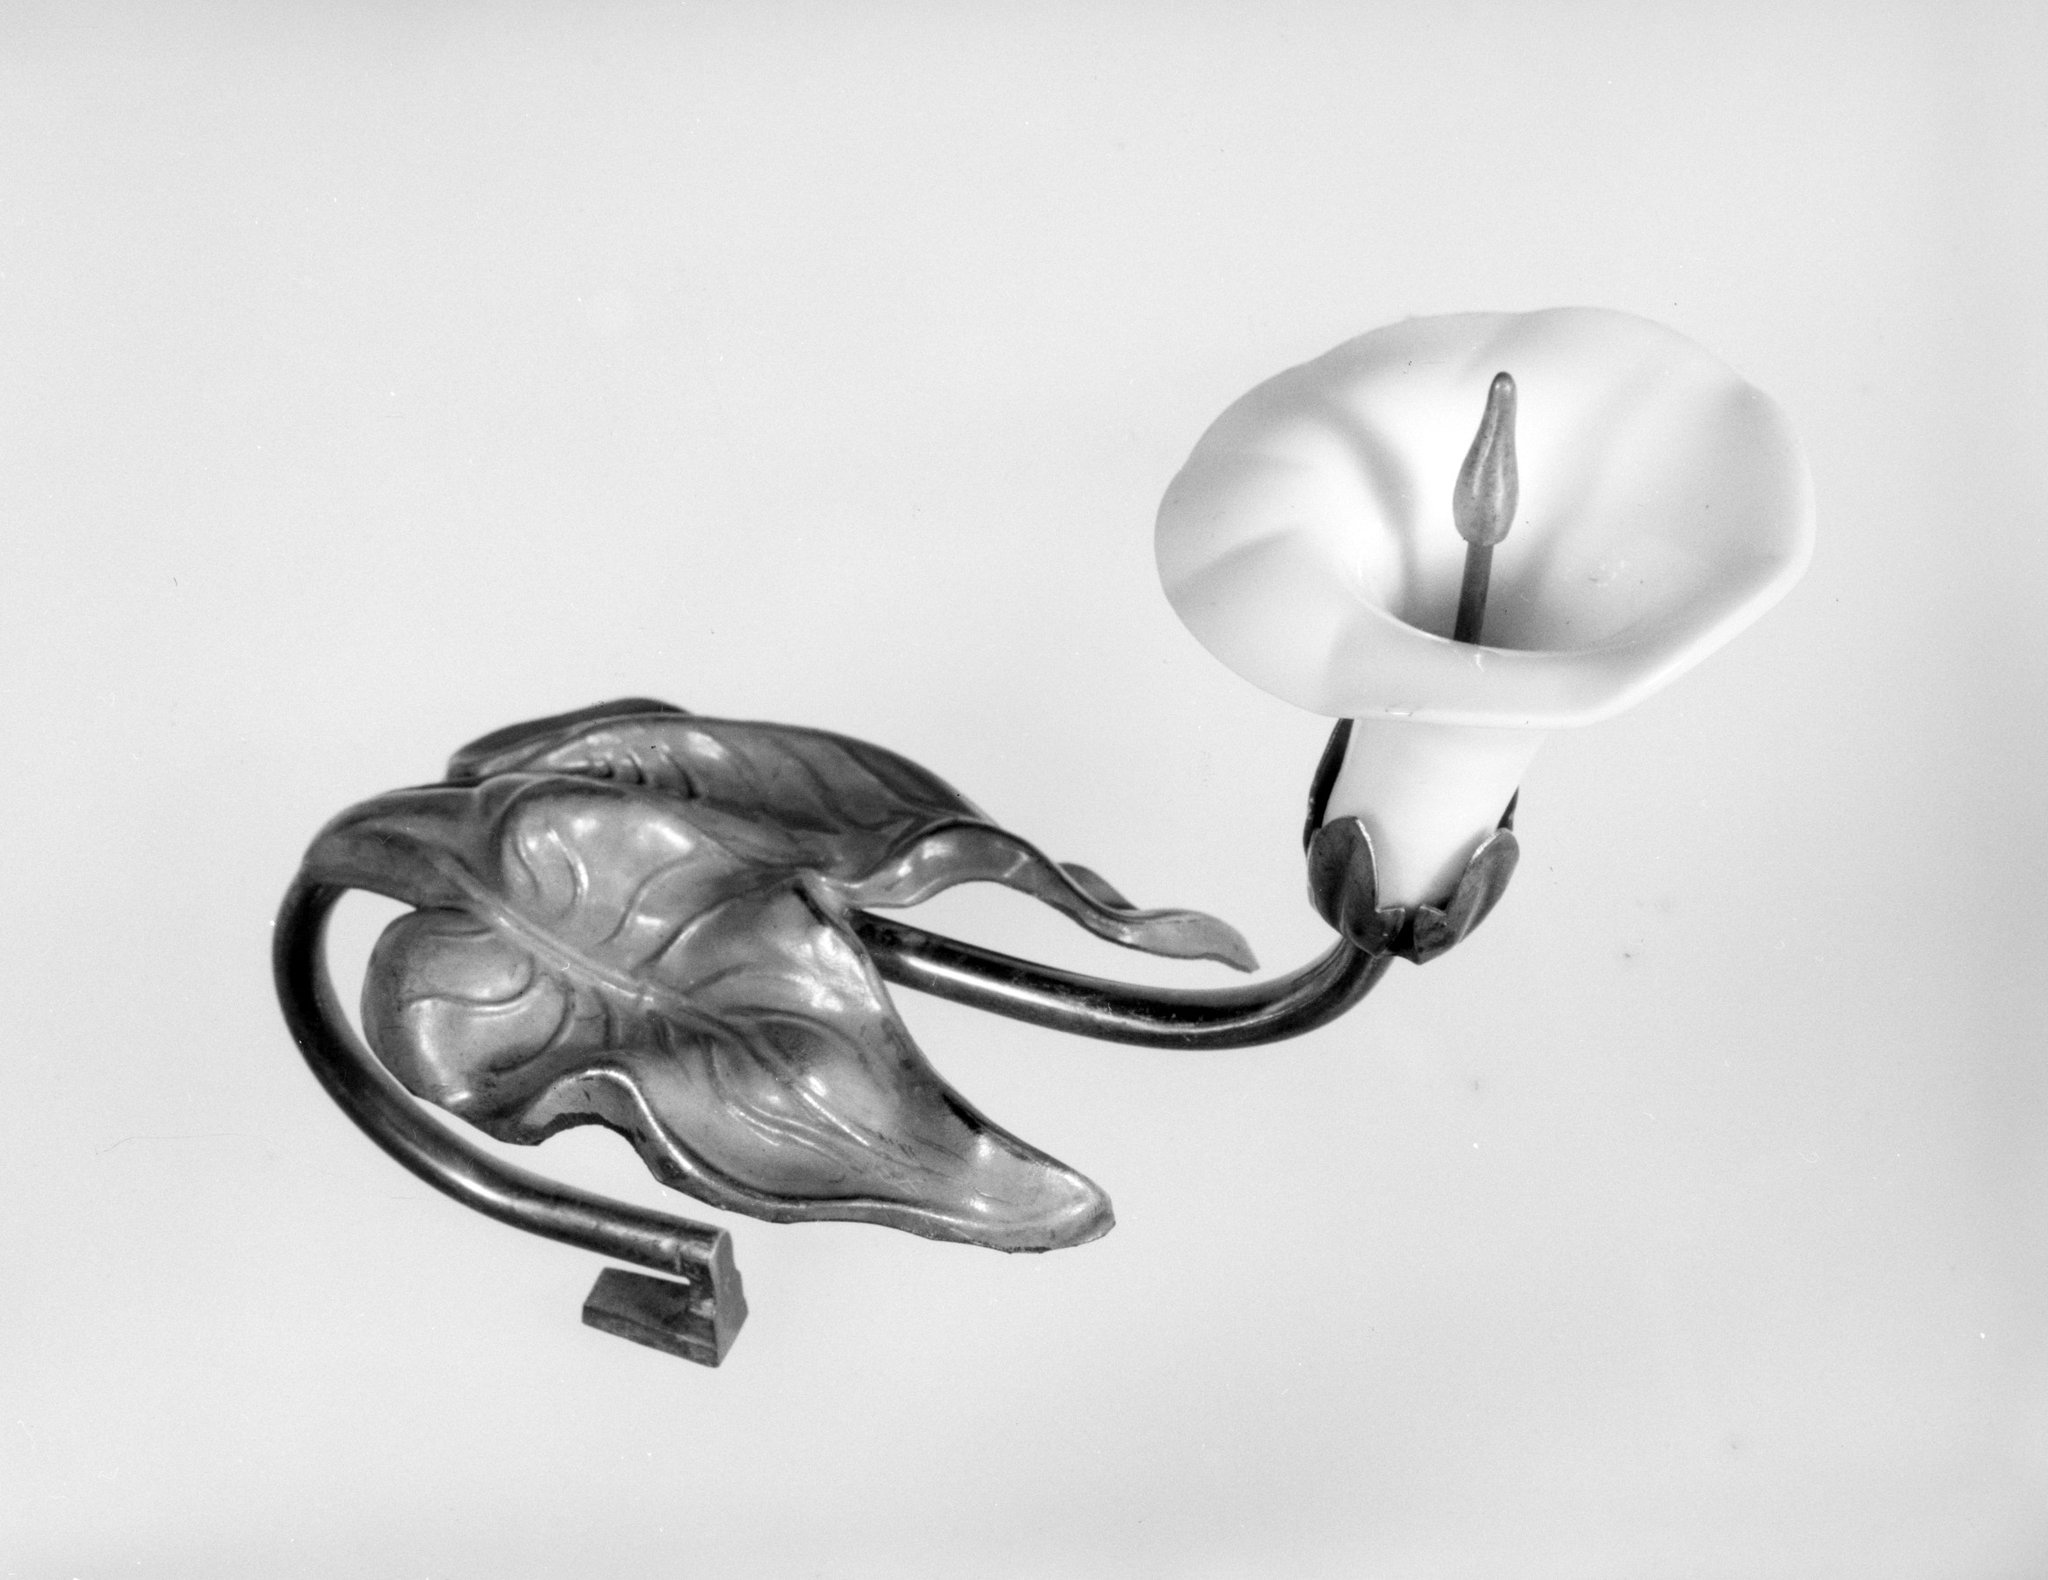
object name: curtain tieback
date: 1880-1895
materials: brass, glass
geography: england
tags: flowers